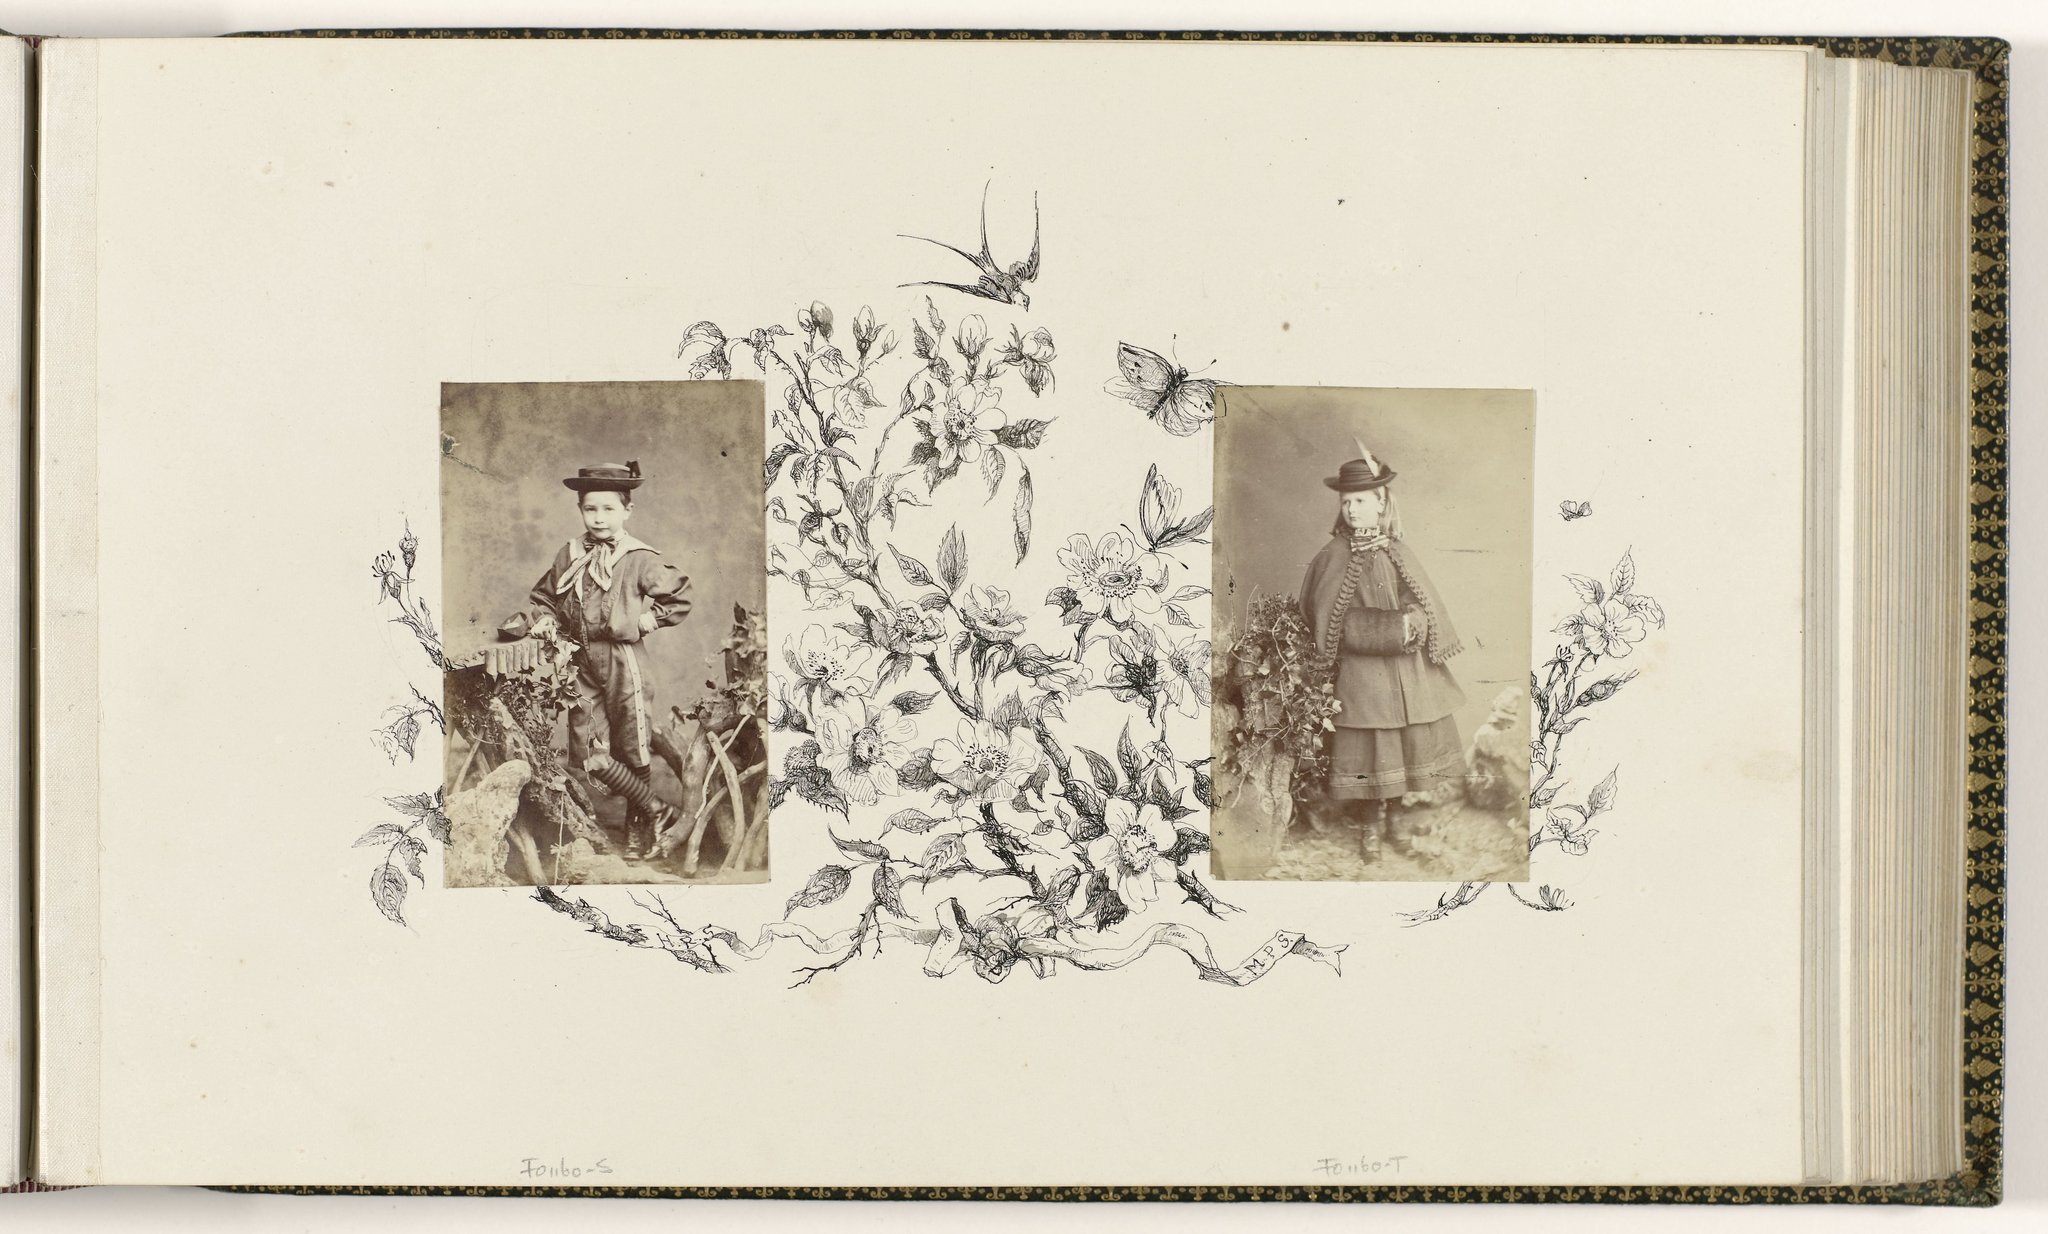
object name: photograph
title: Portret van een onbekende jongen, aangeduid H.R. Salmon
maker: Anonymous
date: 1865-1875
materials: paper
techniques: albumen print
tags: boy (child between toddler and youth), historical persons